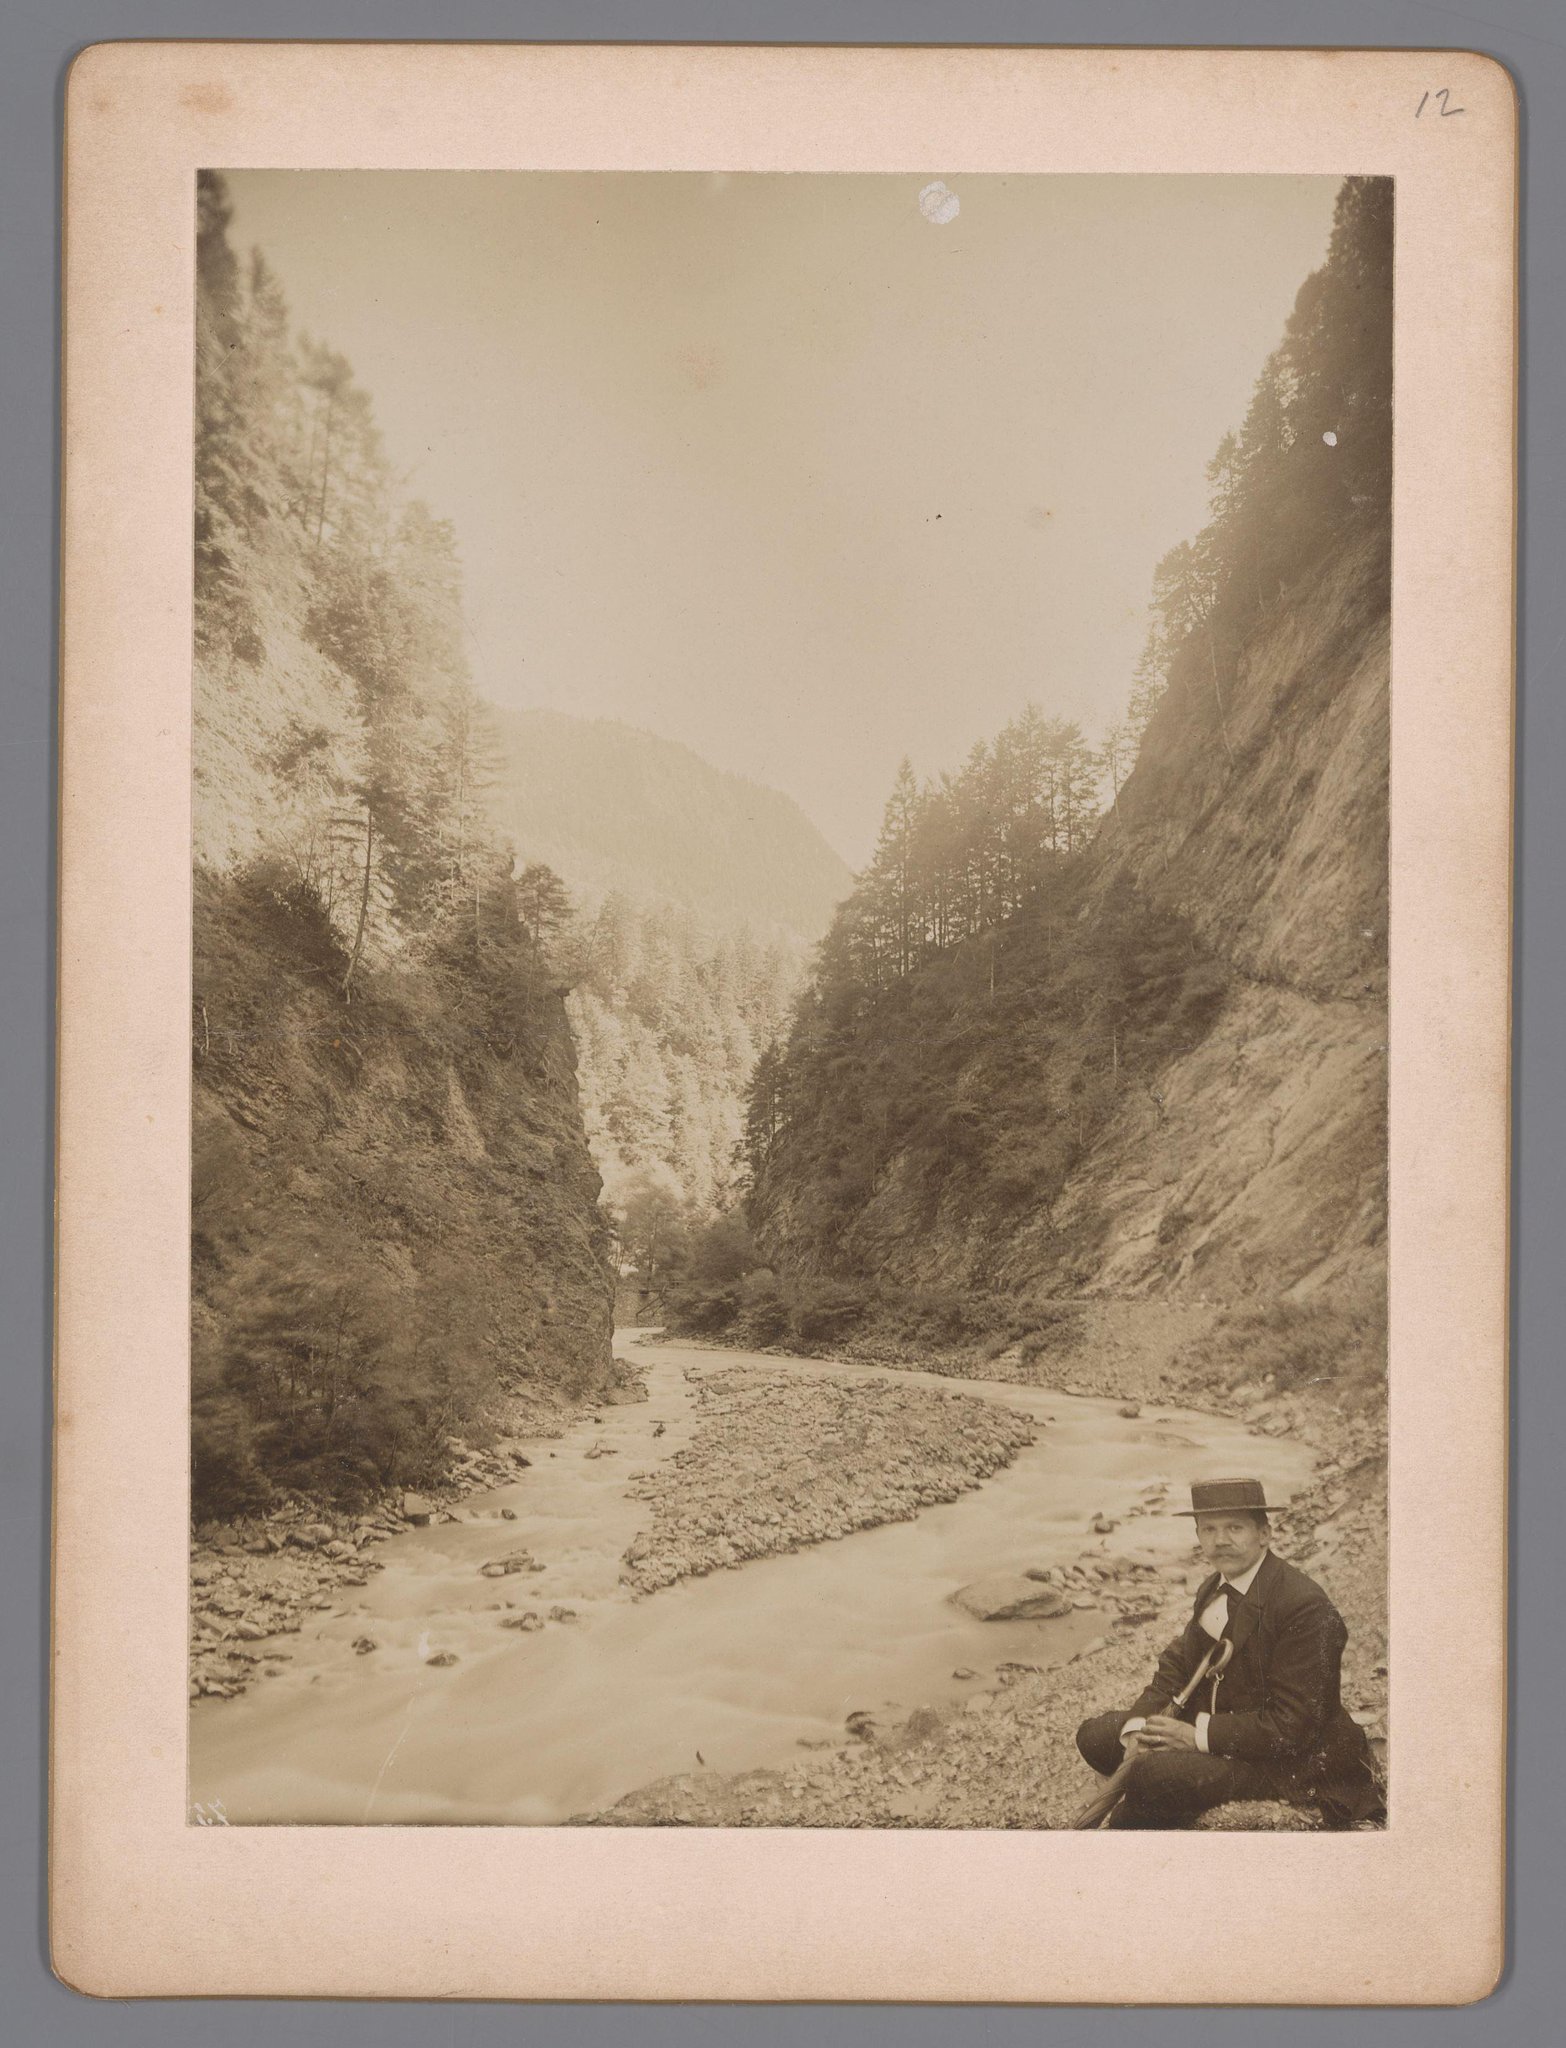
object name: photograph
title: Man in de Taminakloof bij Pfäfers en Bad Ragaz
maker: Anonymous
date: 1890-1930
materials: paper, cardboard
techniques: gelatin silver print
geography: taminakloof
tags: mountains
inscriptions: inscription: ‘Strasse van Ragaz./ Phäffers (Taminaschlucht.)/ (Canton Graubunden)’